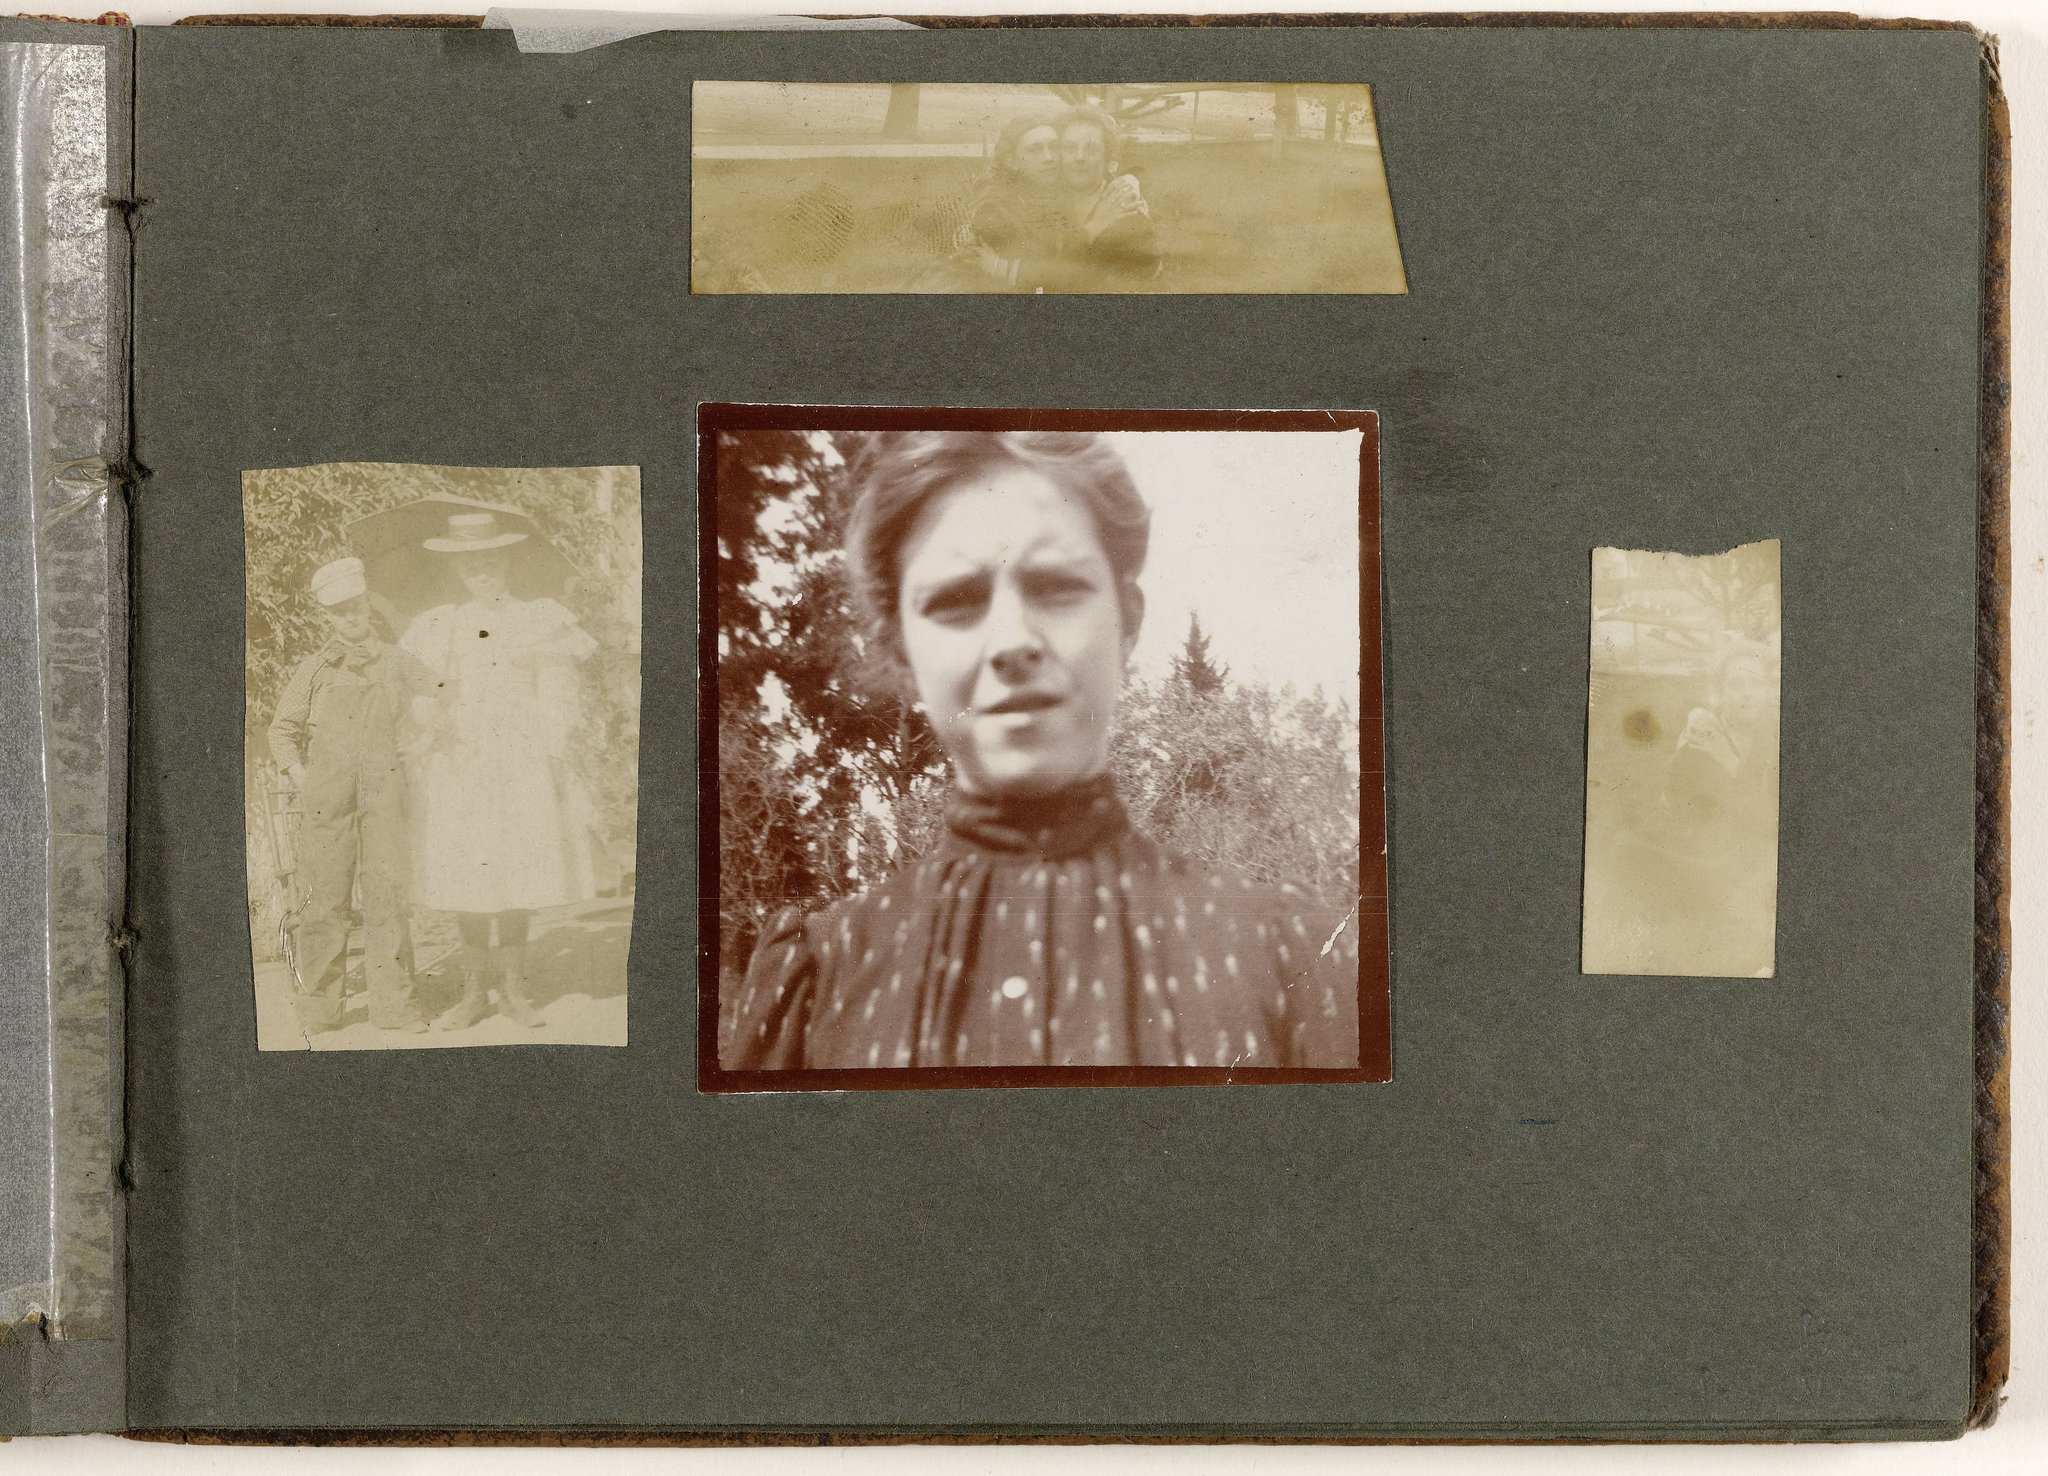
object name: photograph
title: Portret van een jonge vrouw, Verenigde Staten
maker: Anonymous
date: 1900-1920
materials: paper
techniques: gelatin silver print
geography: united states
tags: adolescent, young woman, maiden, historical persons not known by name - bb - woman, united states of america